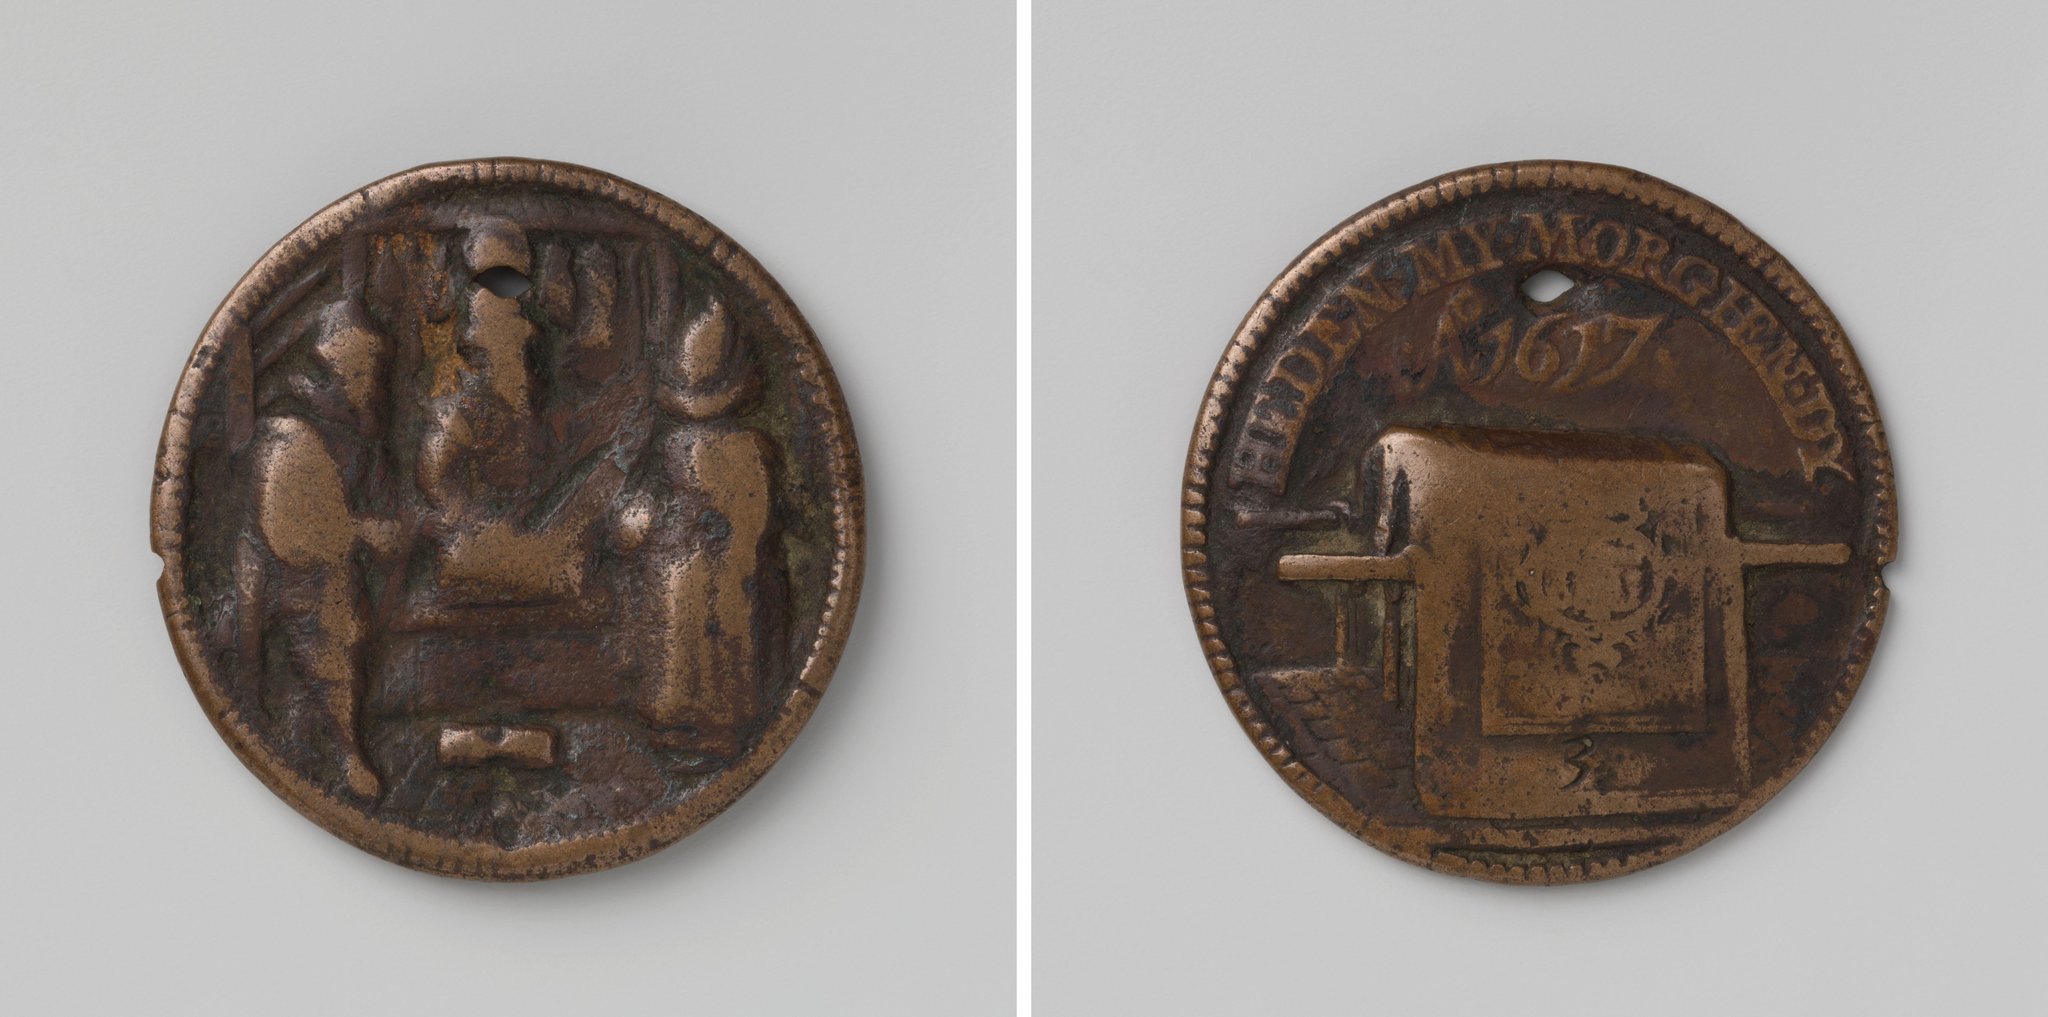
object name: medal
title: Zijdelakenkopers- en -kramersgilde van Middelburg, begrafenispenning met no. 3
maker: Anonymous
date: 1617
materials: brass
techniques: casting, engraving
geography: middelburg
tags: middelburg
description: Messing penning met gat erin. Voorzijde: lakenkoopman, staande achter toonbank in zijn winkel meet met een el stof; links en rechts: man en vrouw. Keerzijde: lijkbaar met cijfer 3 op kleed onder jaartal binnen omschrift